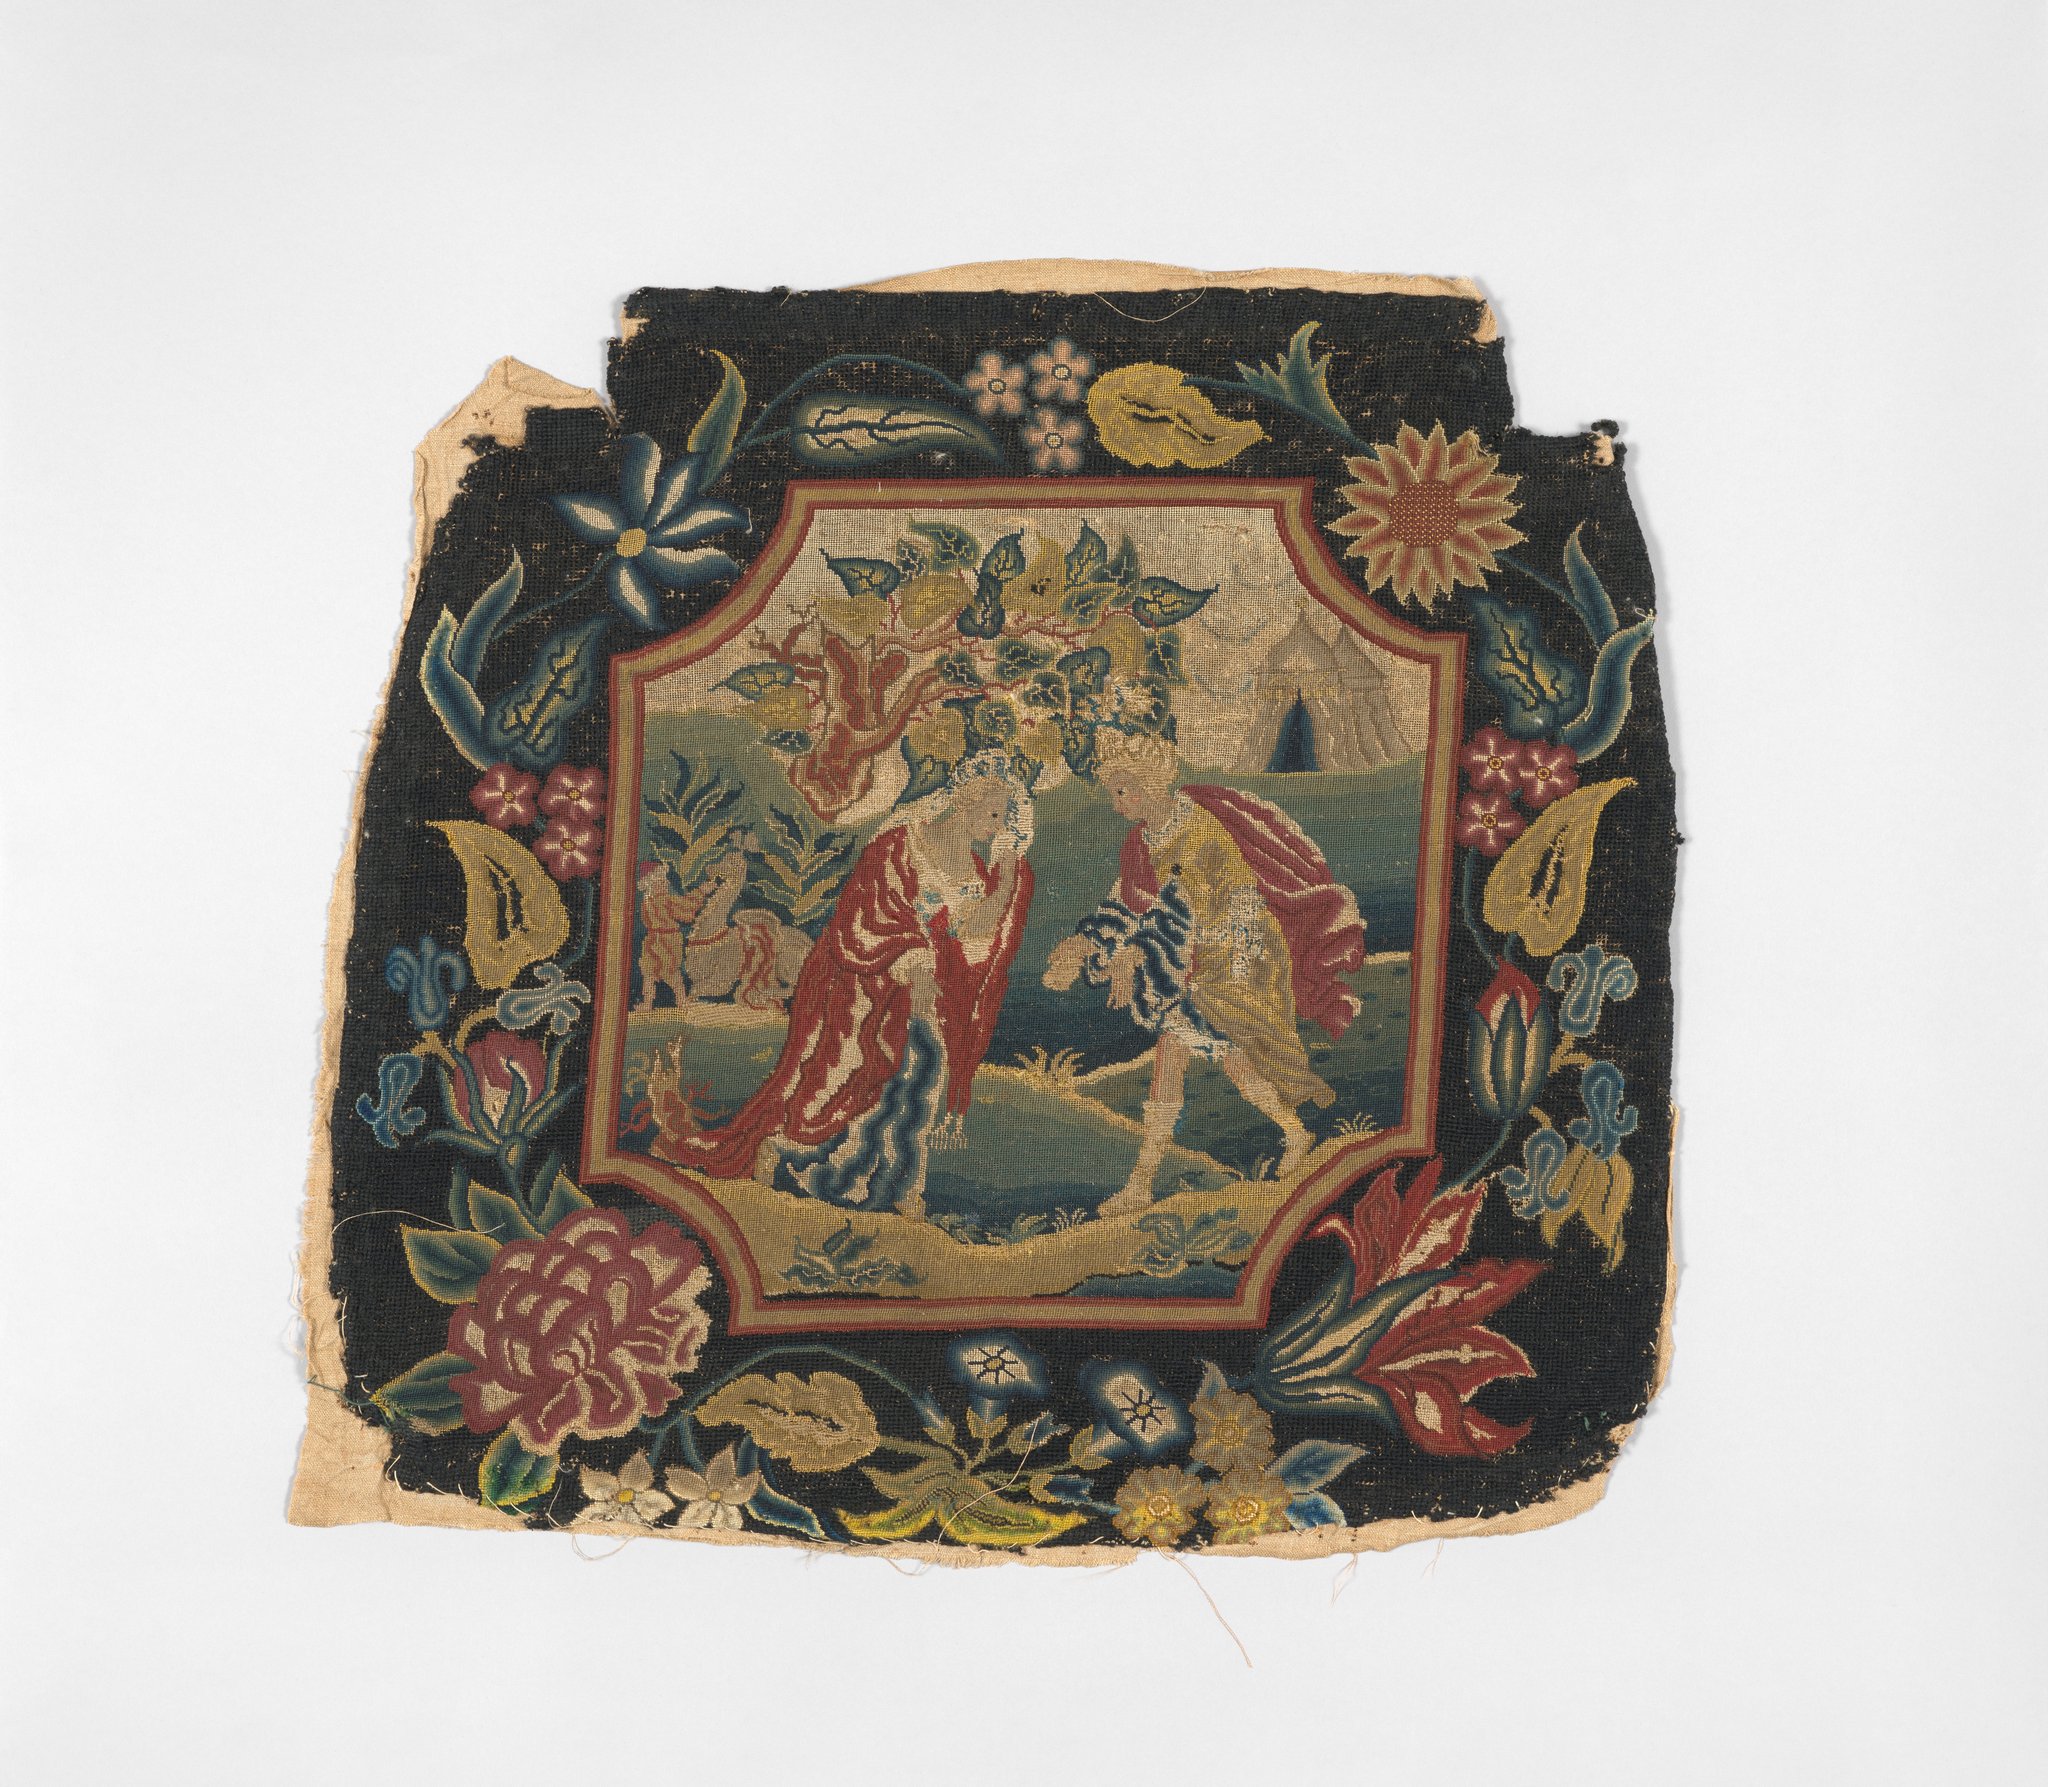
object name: cover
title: Chair seat cover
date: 1734-1766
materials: canvas, silk, wool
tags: men,women